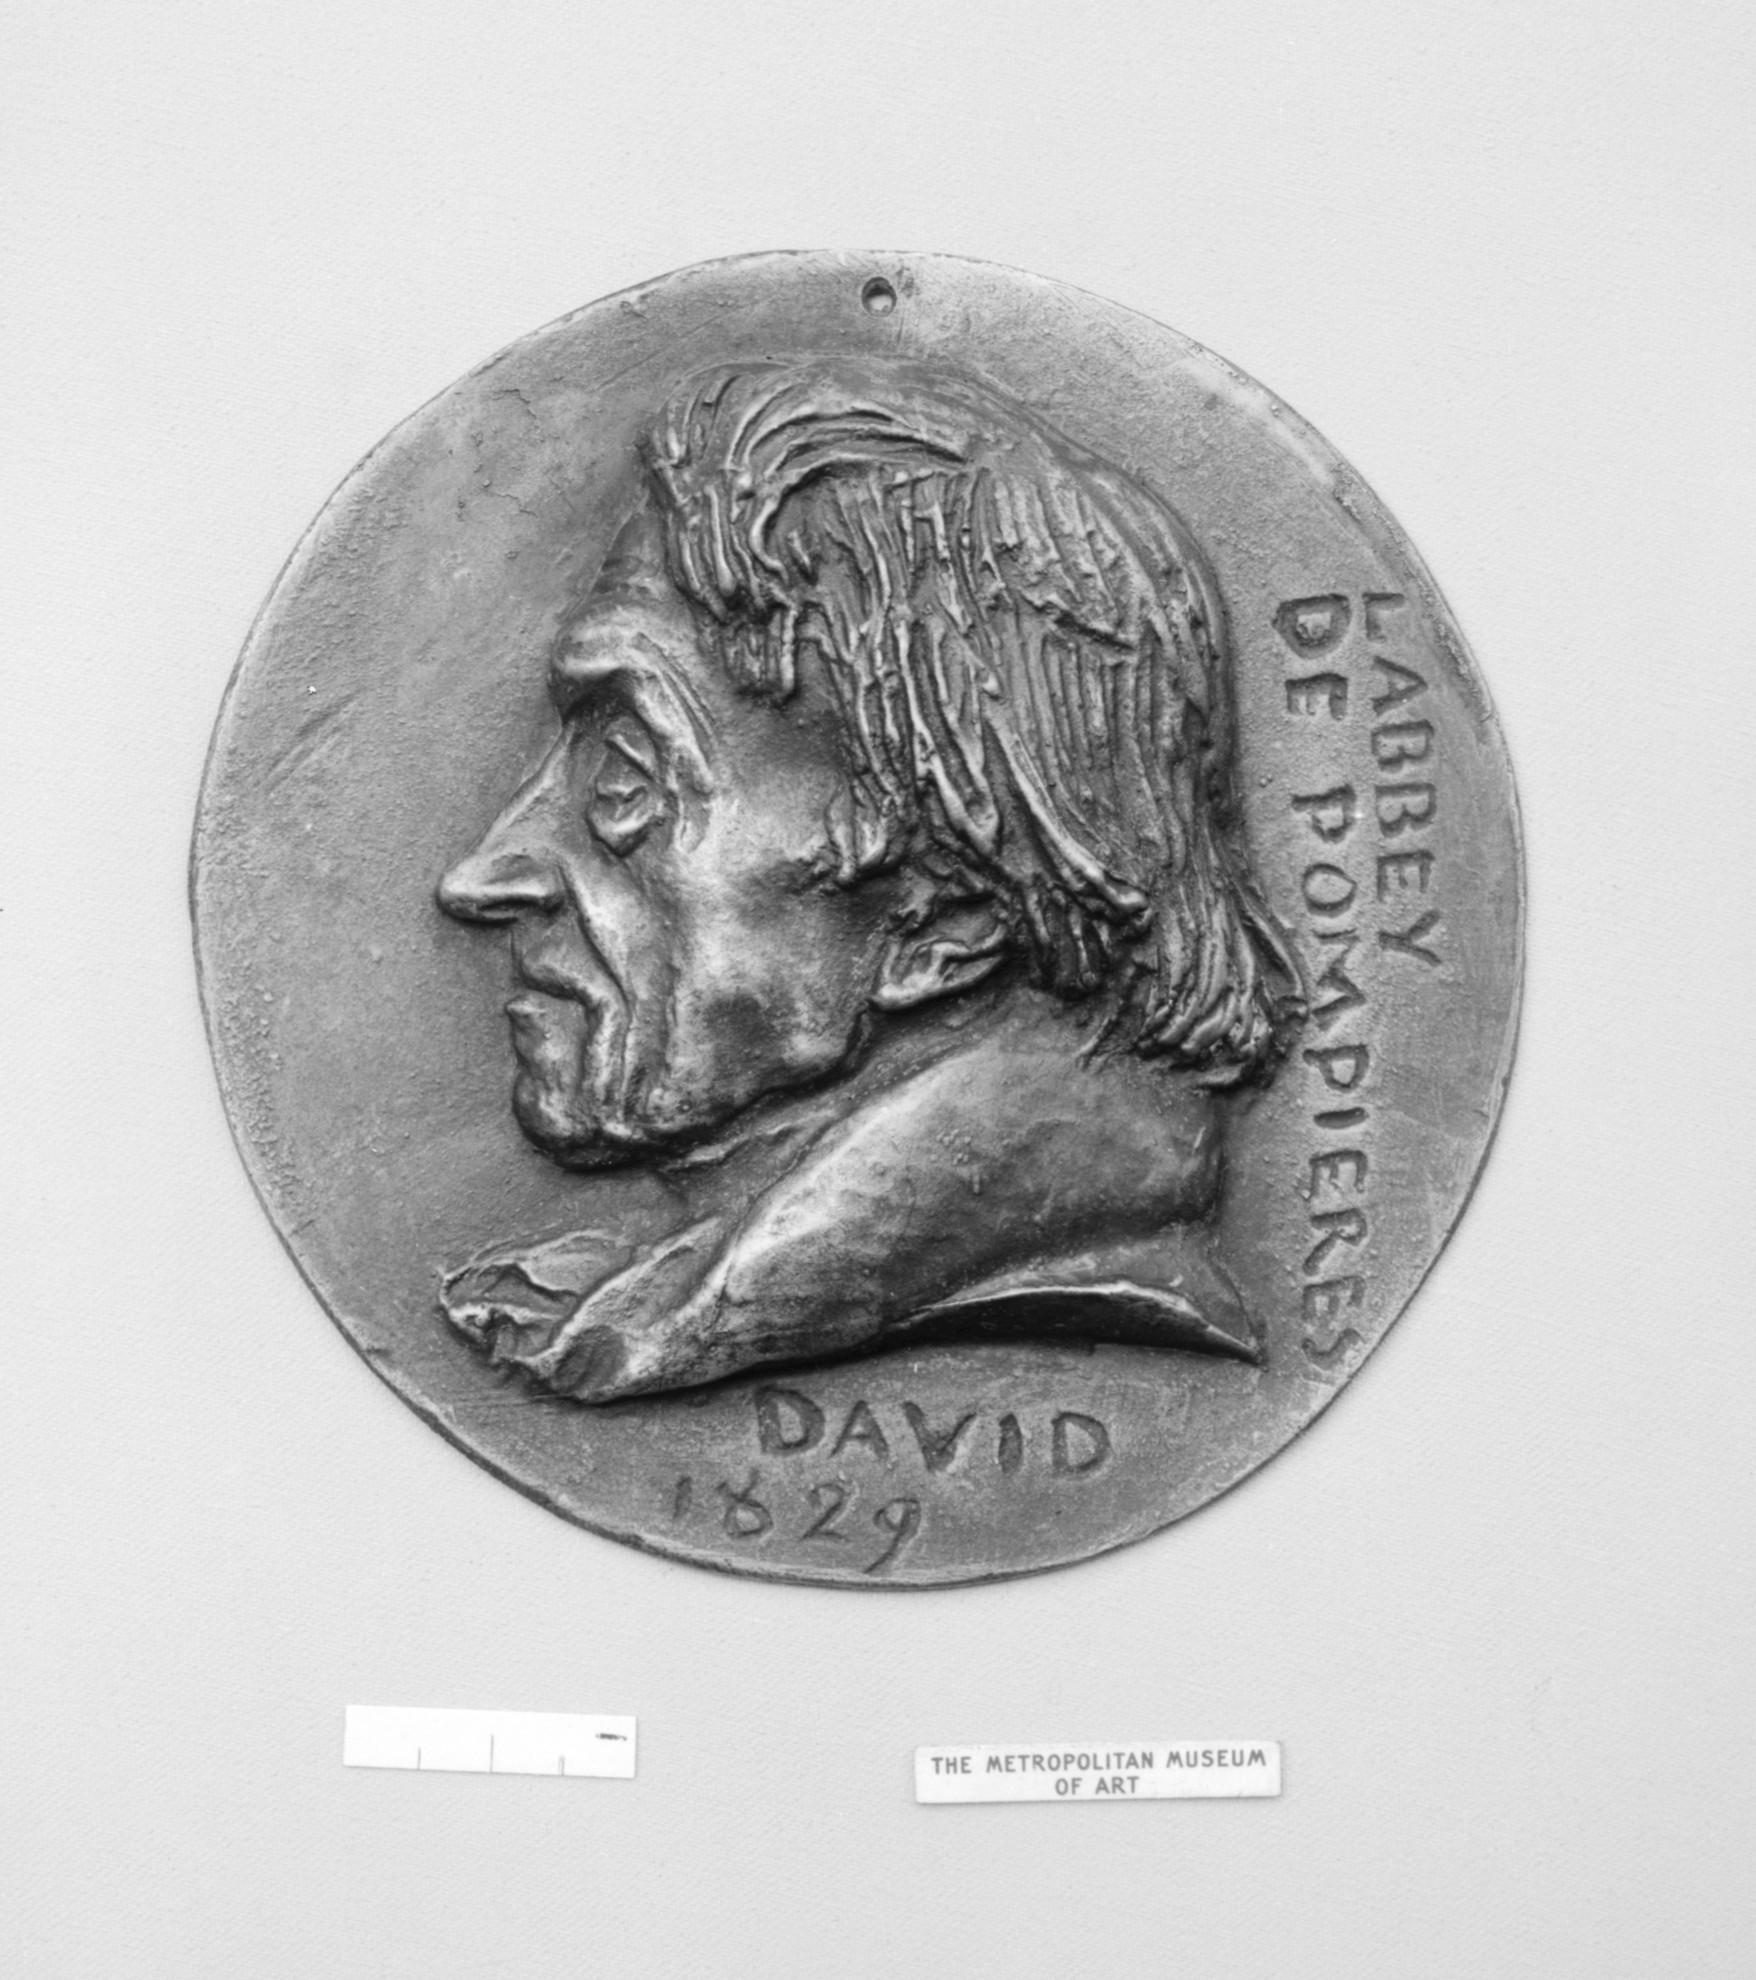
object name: medallion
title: Guillaume Xavier Labbey de Pompiéres (1751–1831), French orator and polititian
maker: pierre jean david d'angers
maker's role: artist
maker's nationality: french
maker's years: 1788-1856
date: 1829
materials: bronze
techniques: casting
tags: men,profiles